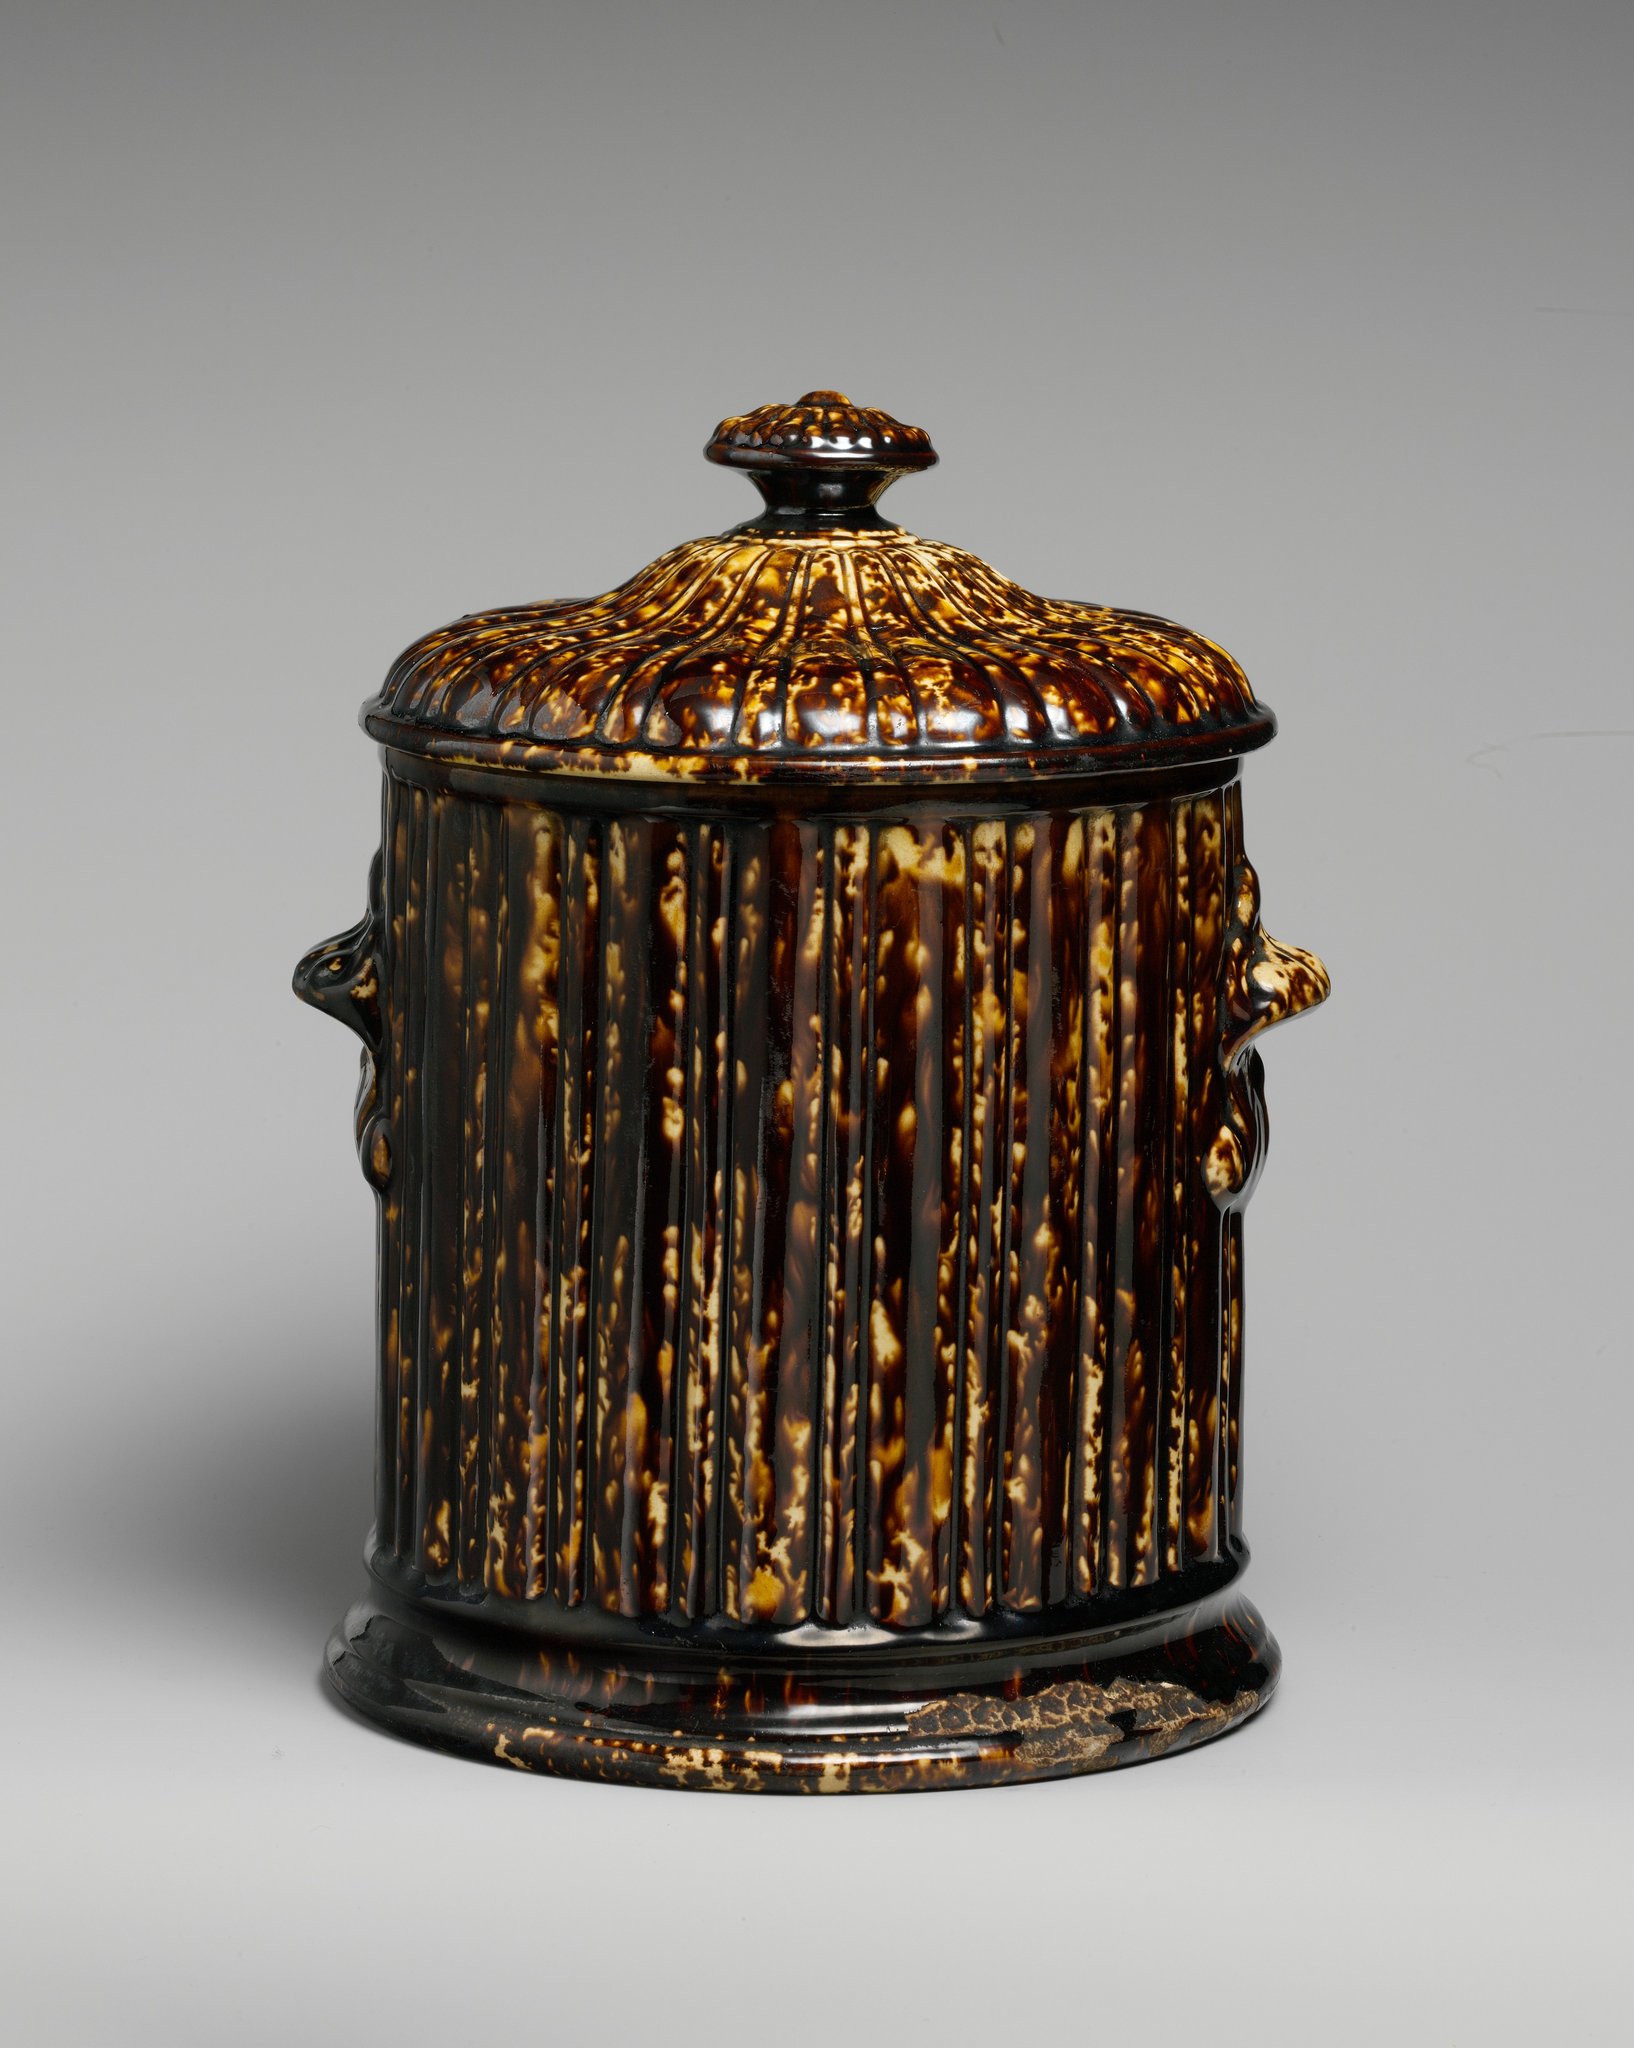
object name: tobacco jar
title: Covered Tobacco Jar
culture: american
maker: lyman, fenton & co.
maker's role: maker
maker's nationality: american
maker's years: 1849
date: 1849-1858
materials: earthenware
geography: united states